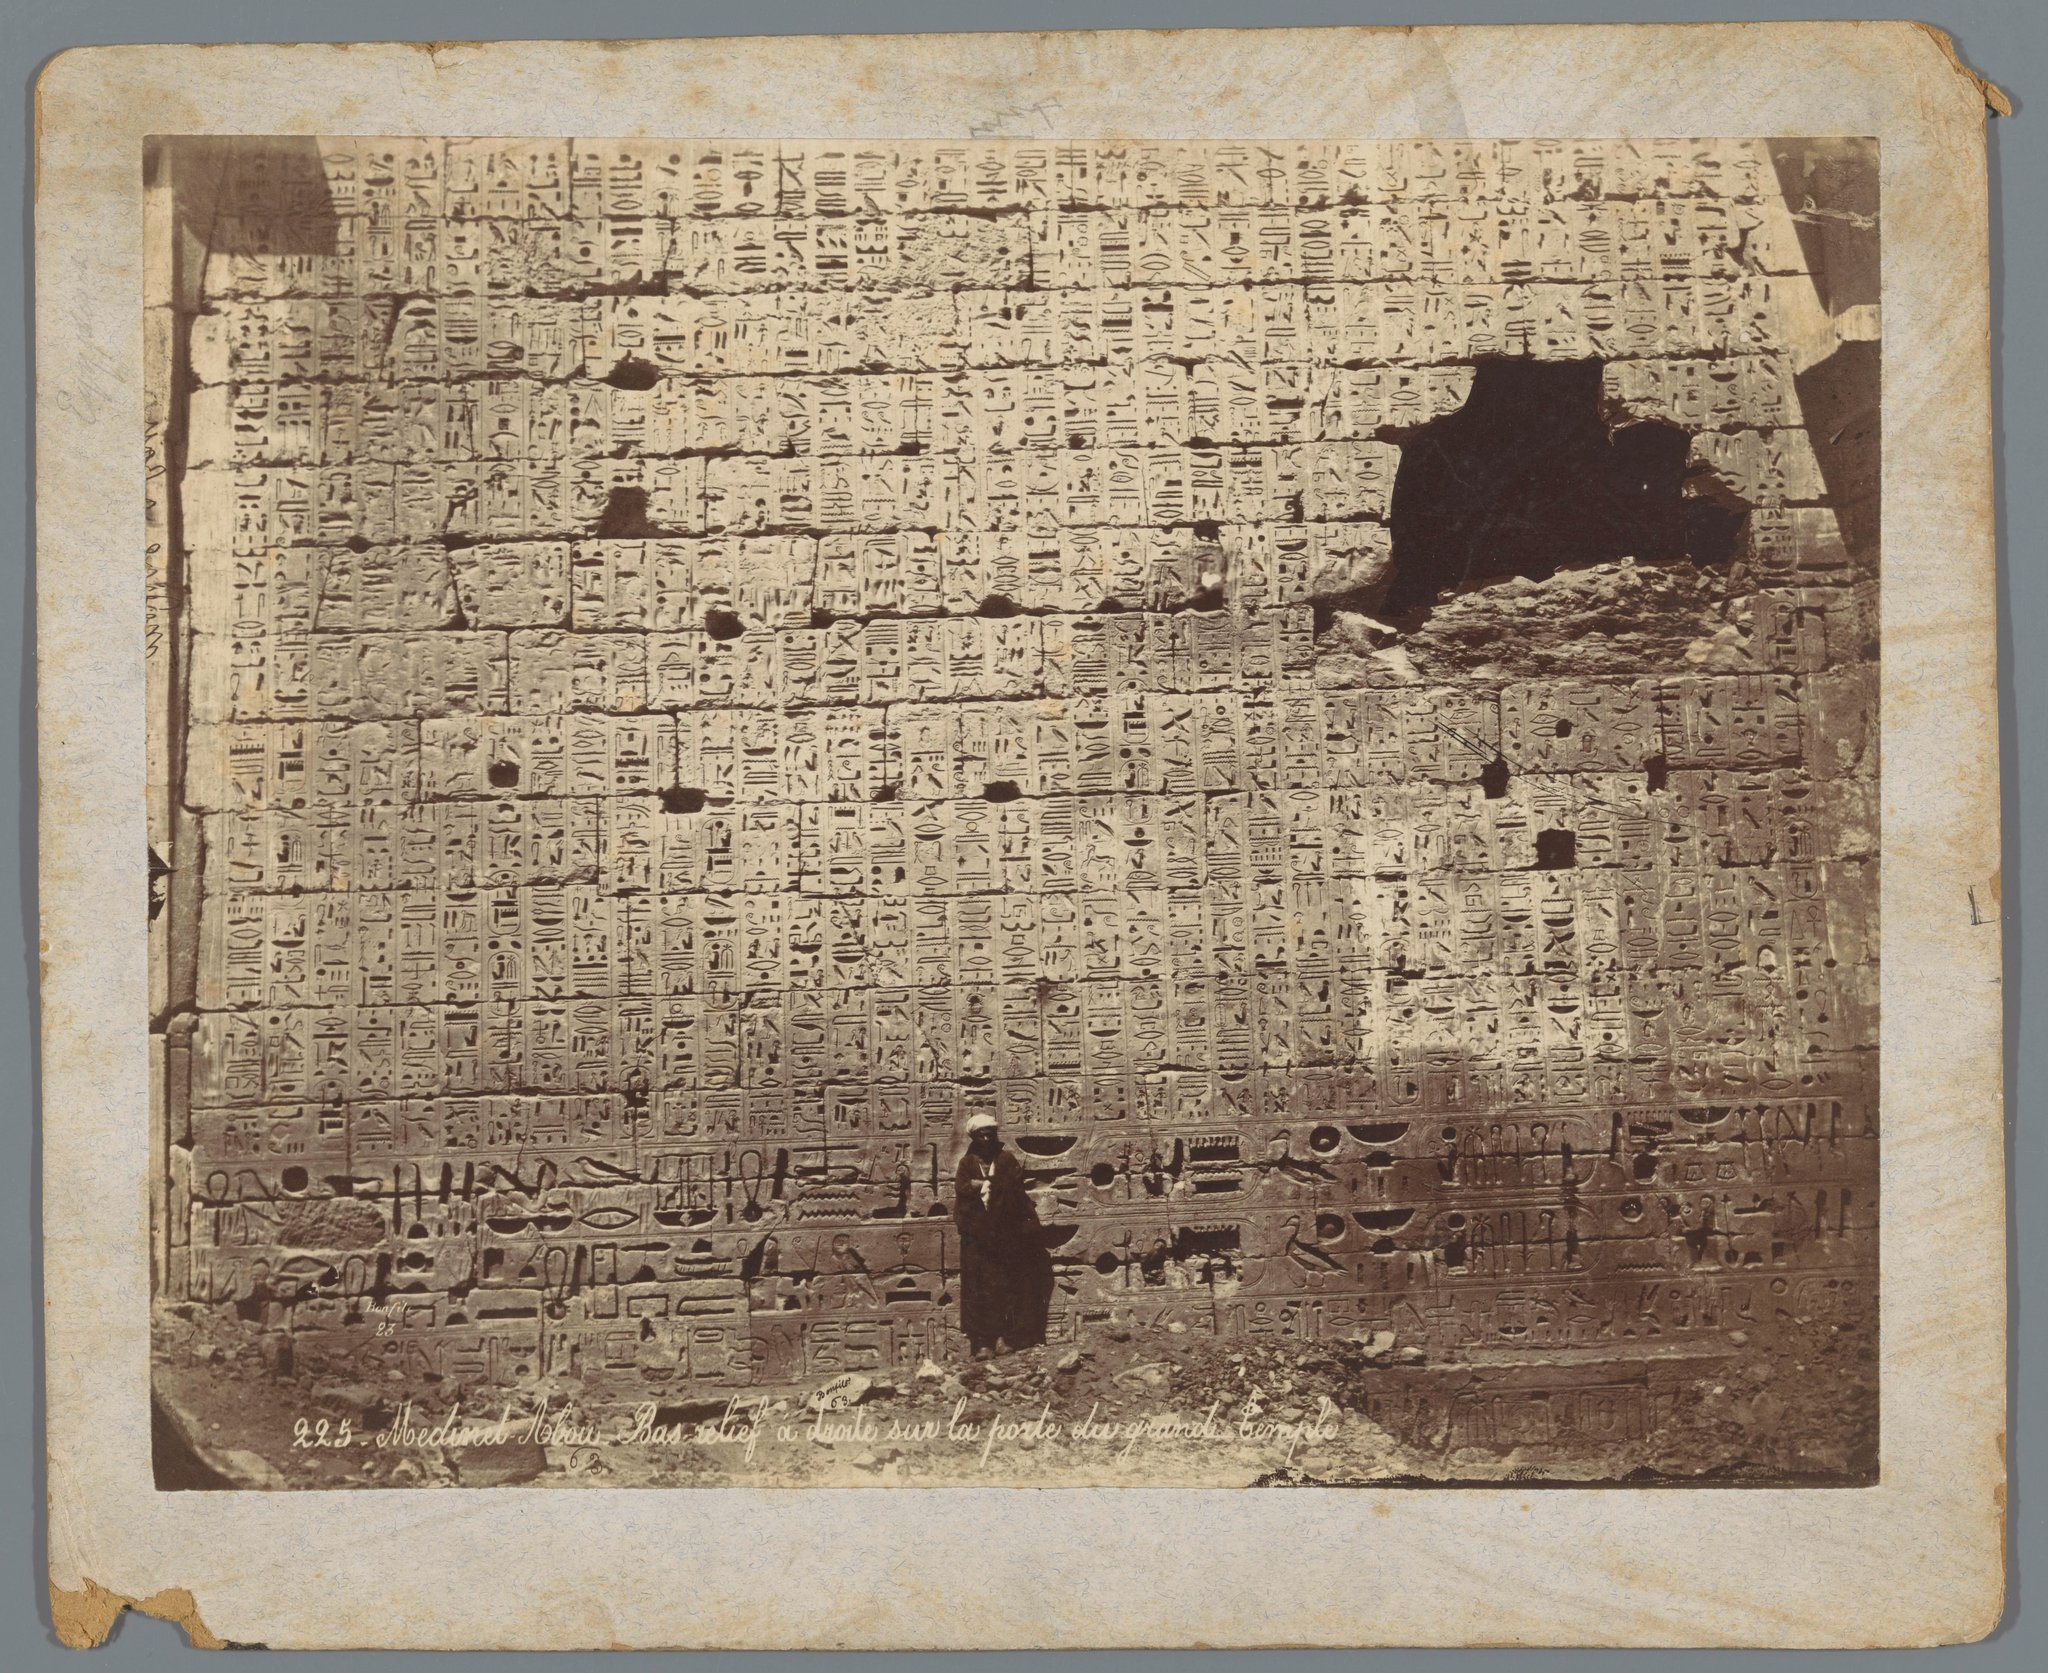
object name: photograph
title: Bas-reliëf op de tempel van Ramses III te Medinet Haboe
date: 1875-1900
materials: cardboard, photographic support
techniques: albumen print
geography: medinet habu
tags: ruin of a building ~ architecture, temple, shrine ~ non-christian religions, exterior ~ representation of a building, sculpture (+ relief ~ sculpture)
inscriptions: collector's mark: Lugt 3937, number: ‘225.’, annotation: